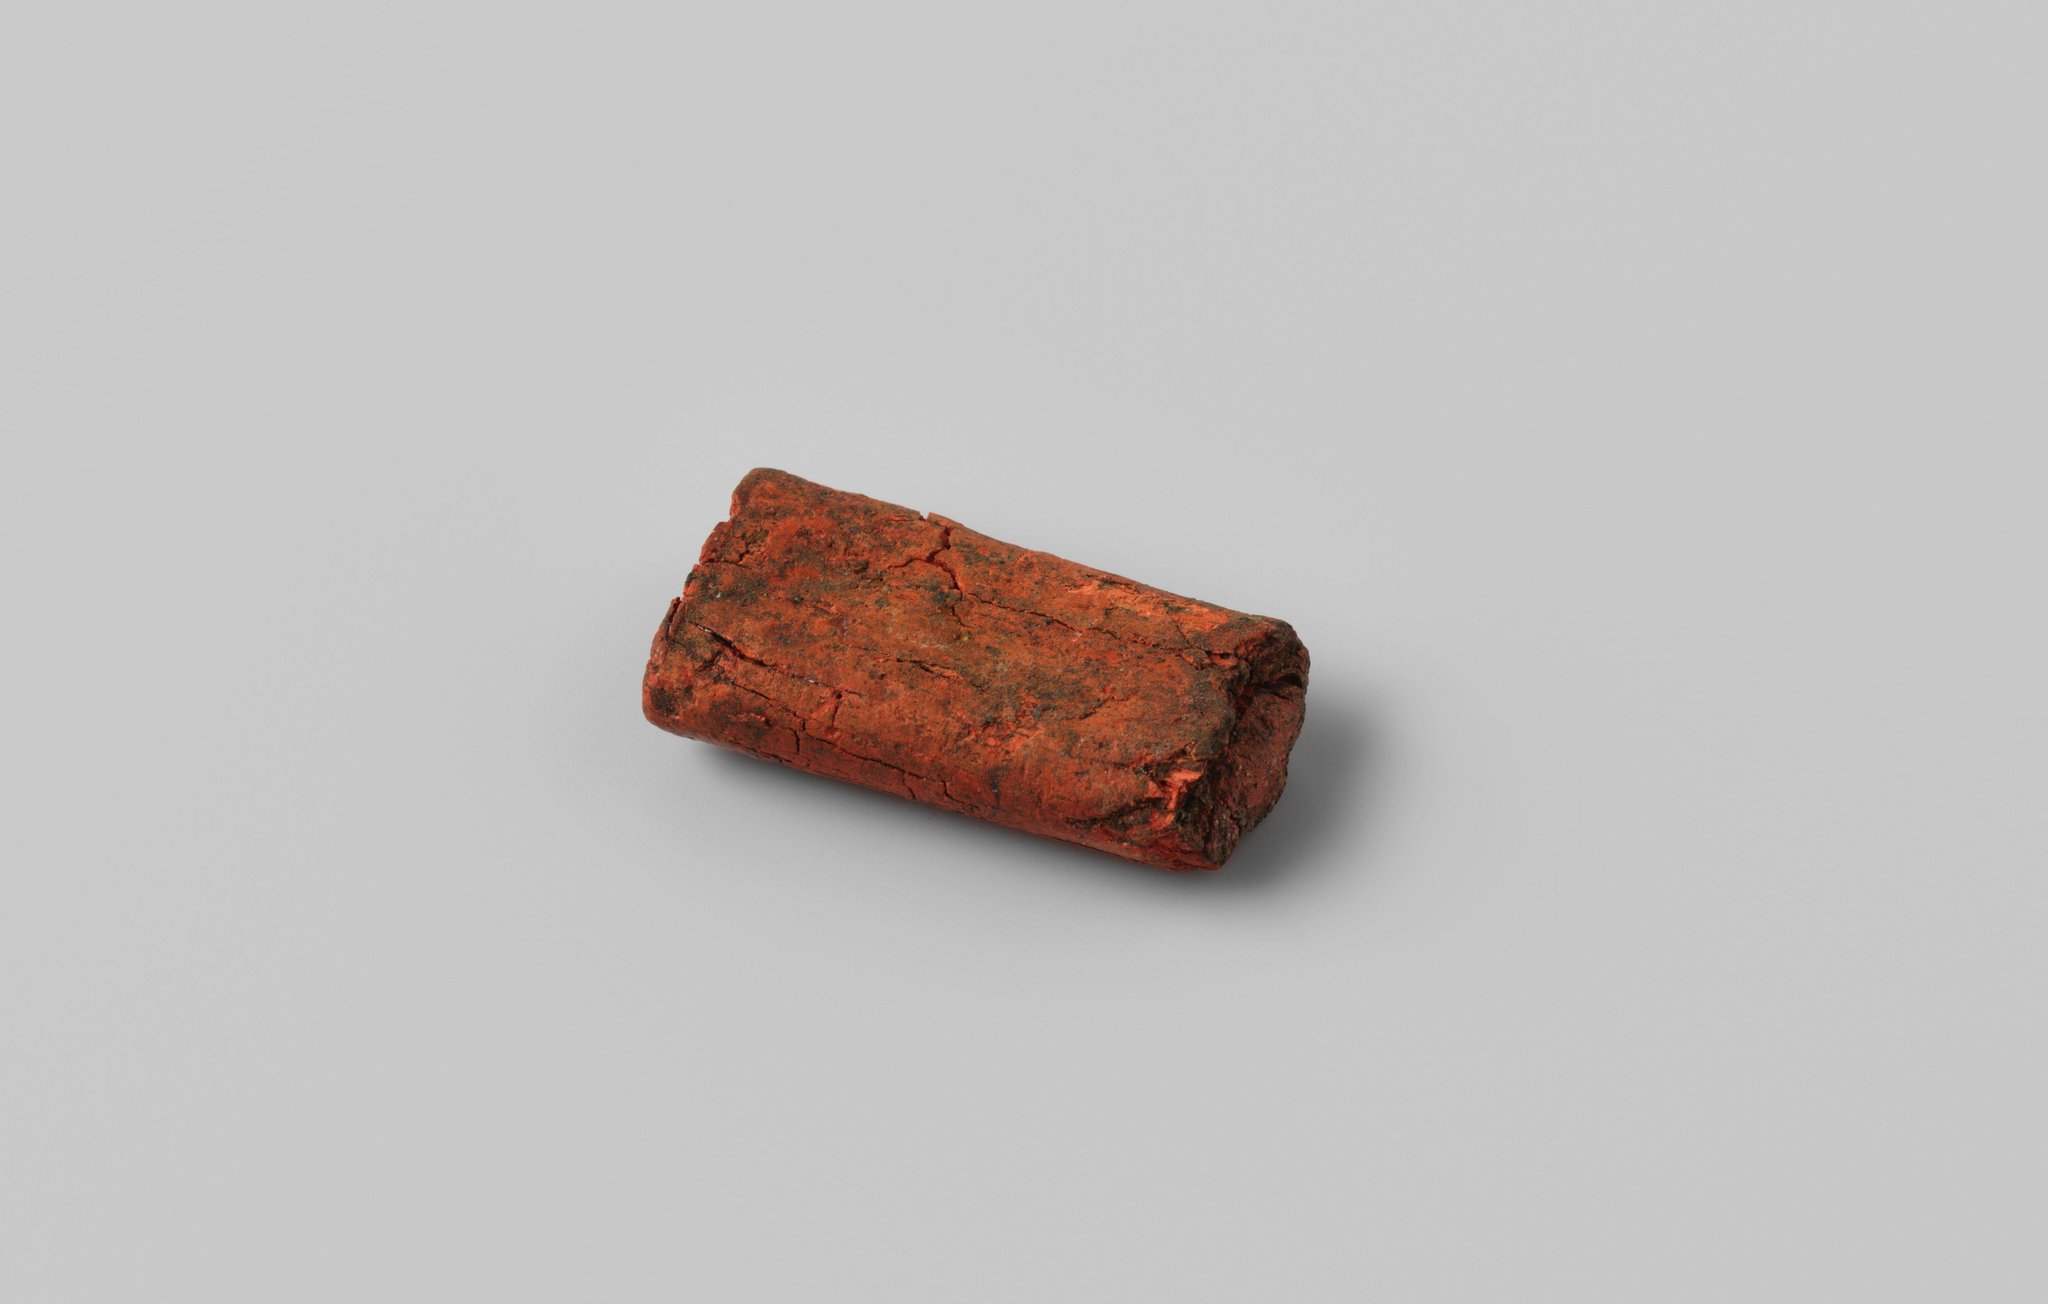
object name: sealing wax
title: Staafje zegellak uit het wrak van de Oost-Indiëvaarder Hollandia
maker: Anonymous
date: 1700-1743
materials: wax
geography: netherlands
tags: verenigde oostindische compagnie, hollandia (schip), annet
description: Marking and proving, sealing wax, red; fragm, id. 50H446.